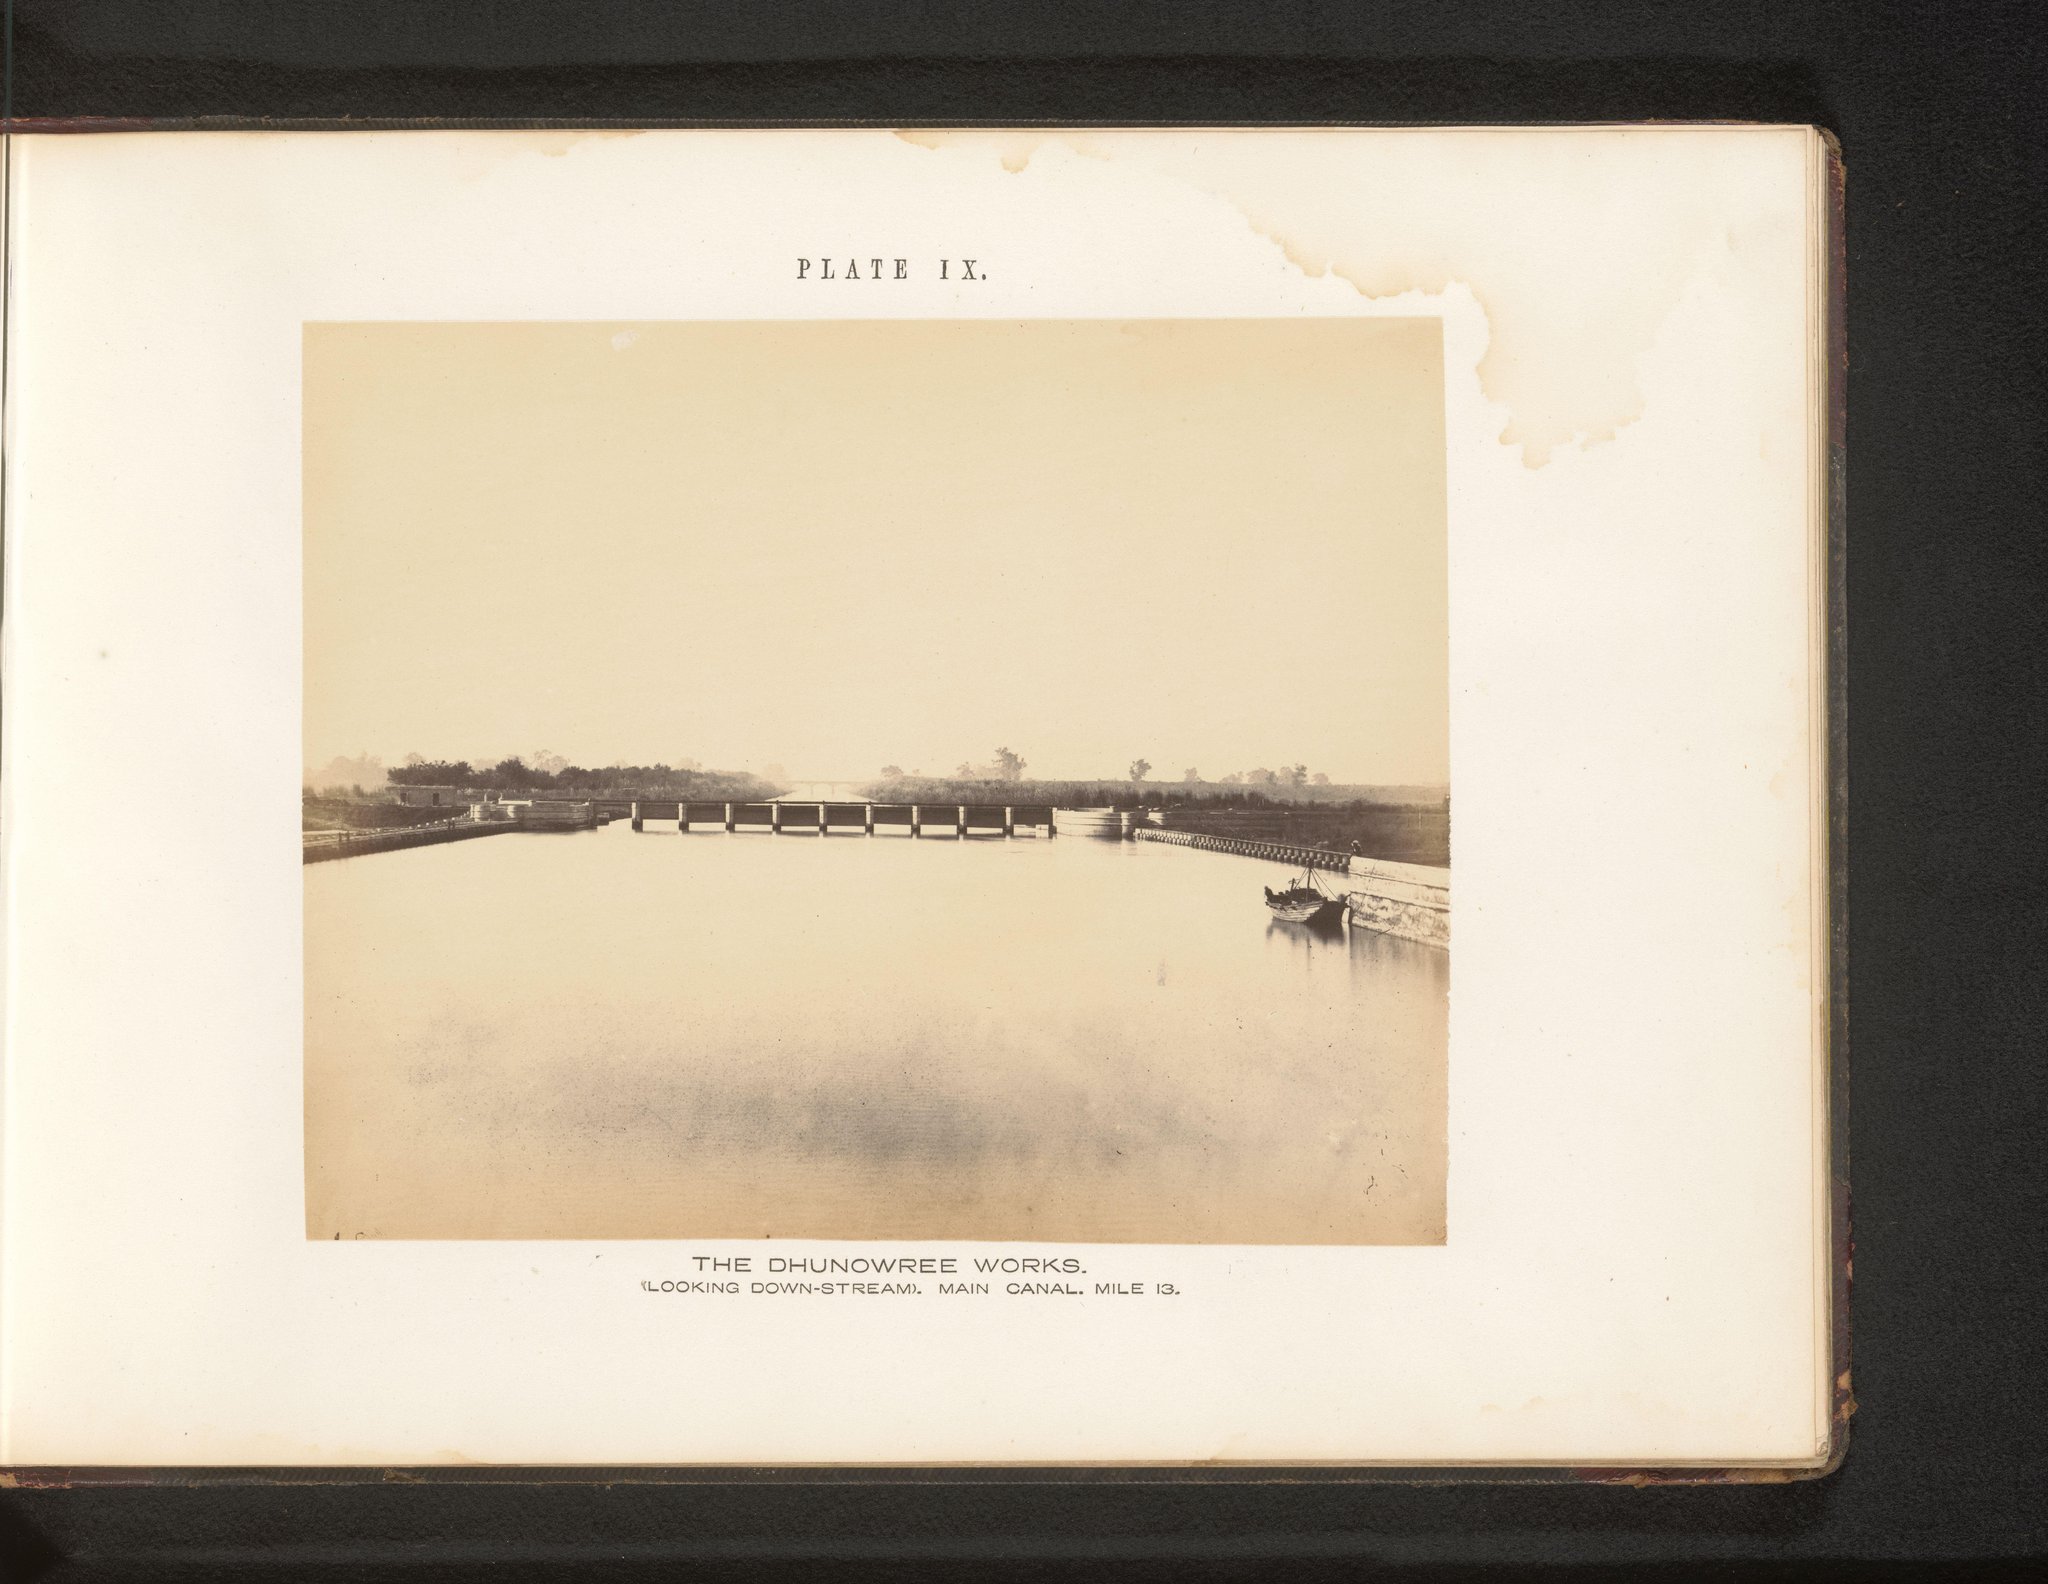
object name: page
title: Gezicht op waterwerken bij een kruising van de Ganges met een andere rivier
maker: thomas george glover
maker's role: fotograaf, luitenant-kolonel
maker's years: 1825-1881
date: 1862-1867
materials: photographic support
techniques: albumen print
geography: india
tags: river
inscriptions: inscription: ‘main canal. mile 13.’, inscription: ‘Plate IX’